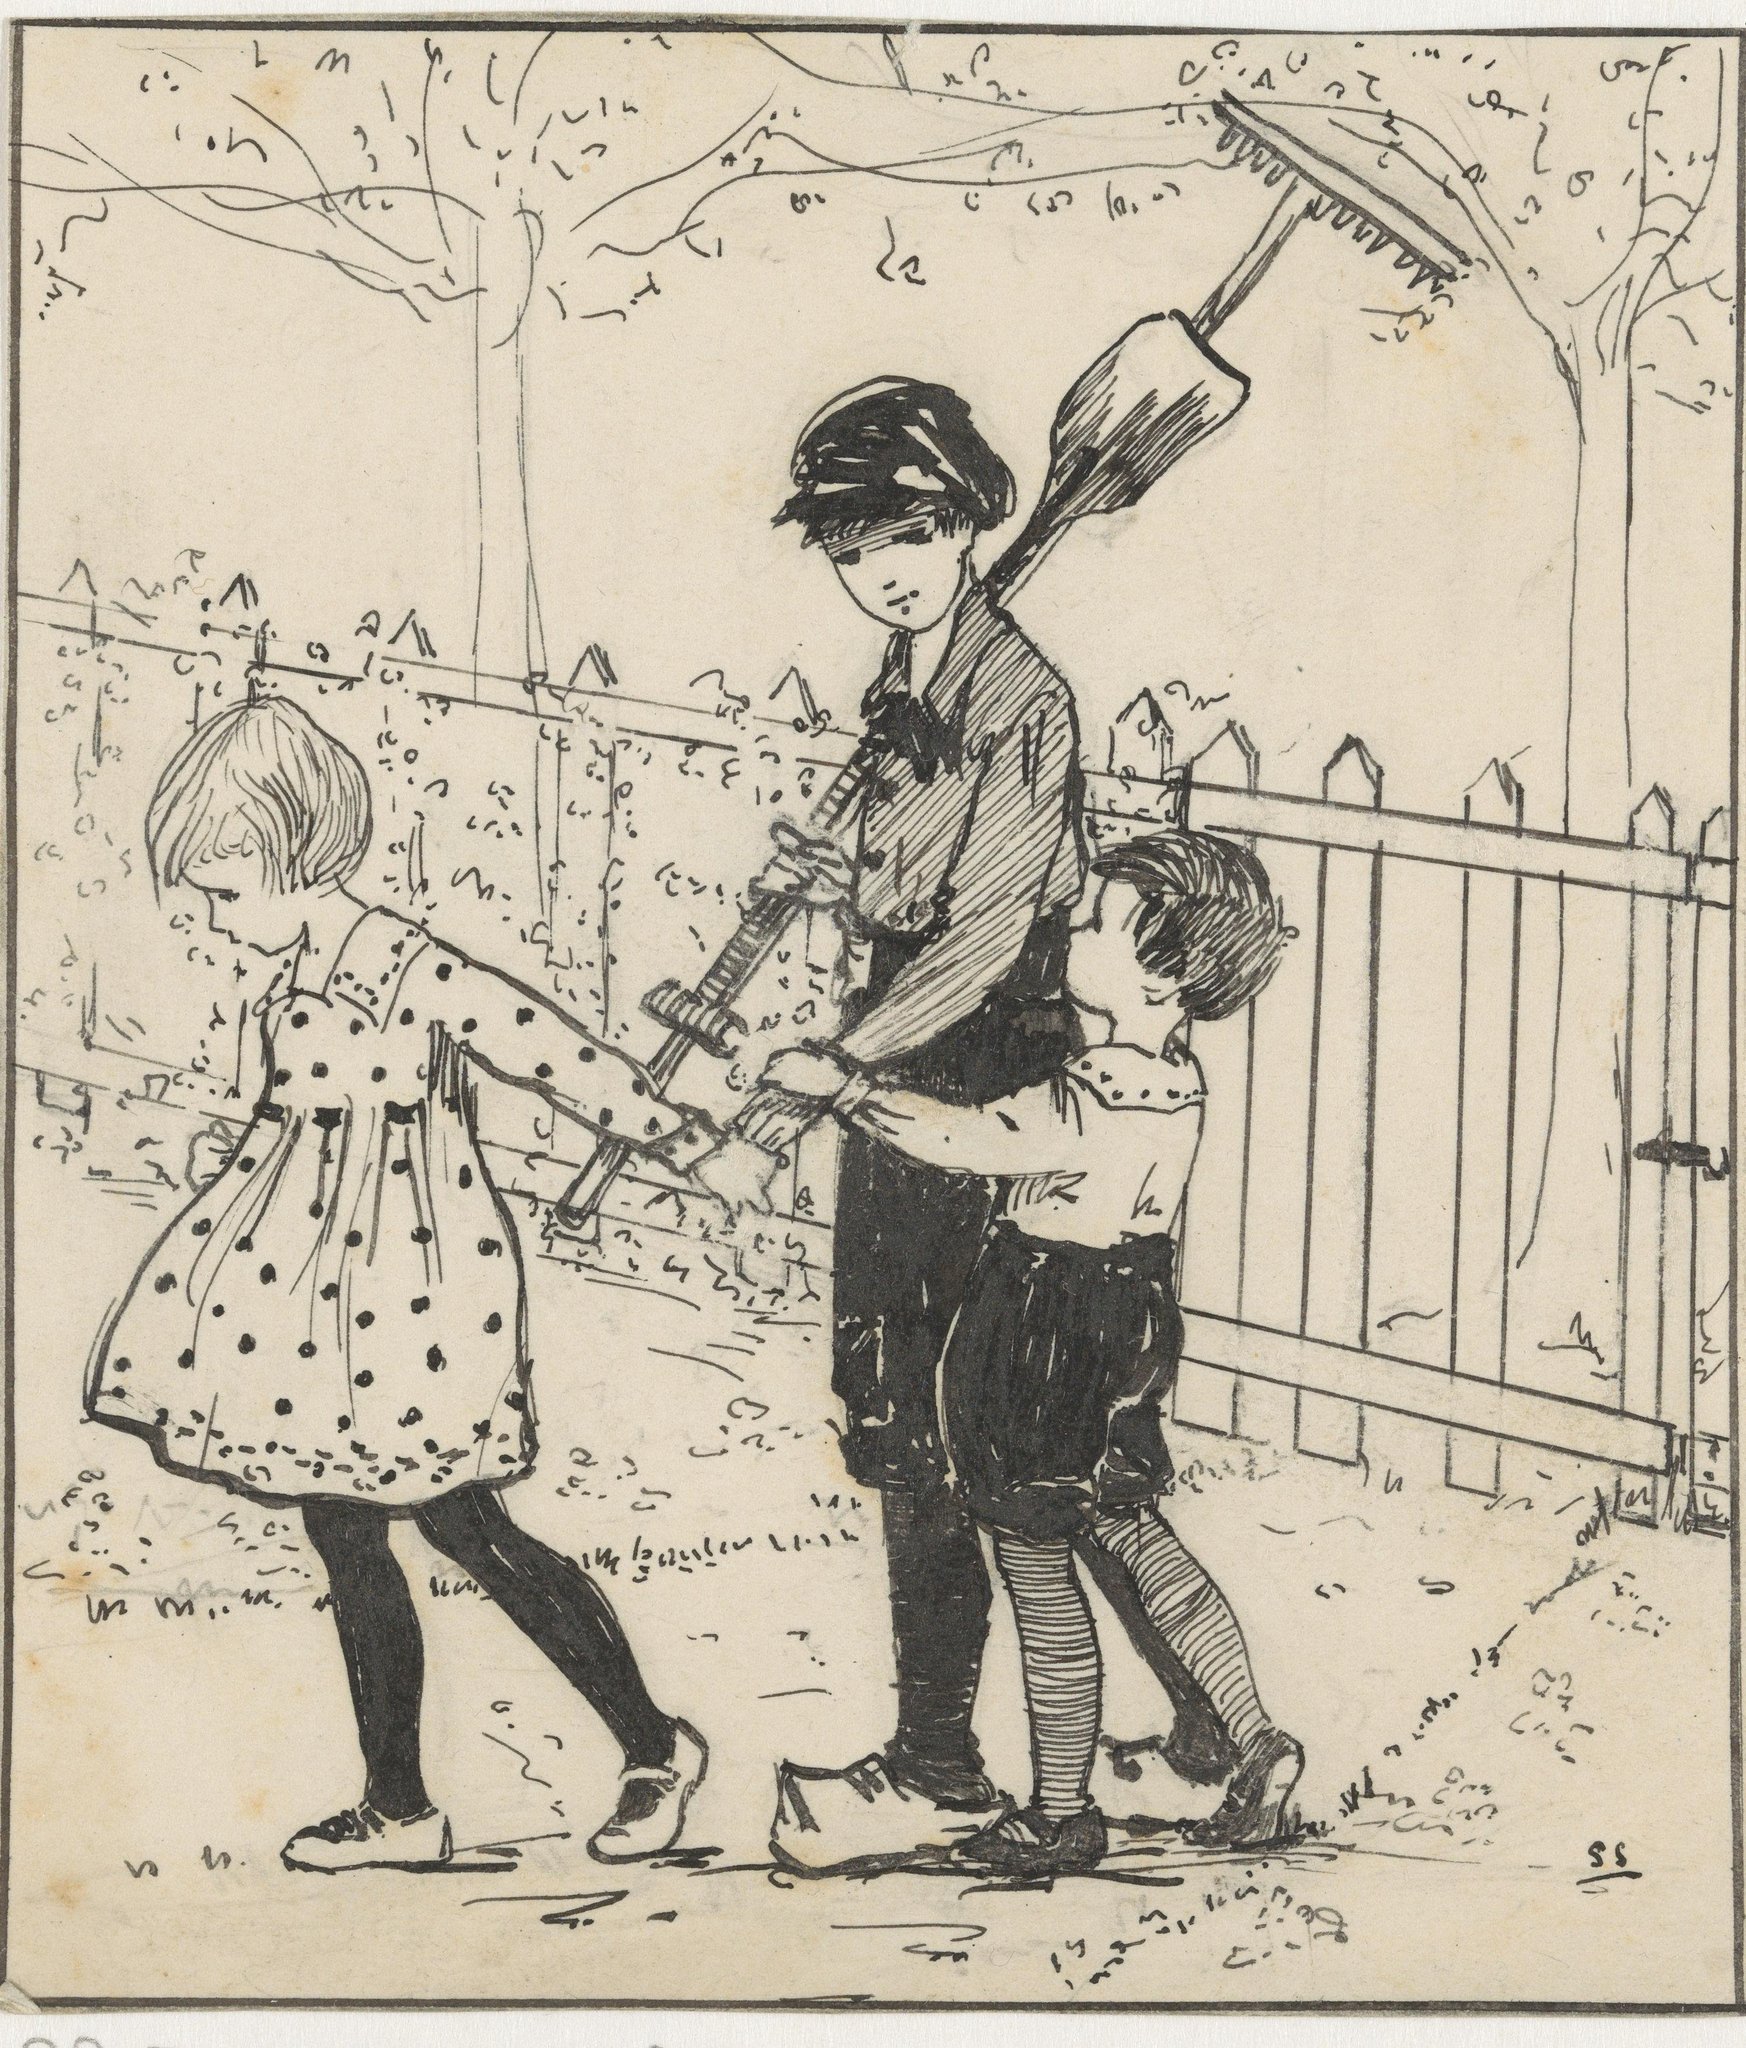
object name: boekillustratie ontwerp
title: Kinderen trekken aan arm van een jongen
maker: Anonymous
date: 1880-1930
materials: cardboard, ink, pencil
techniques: brush, pen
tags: fence, wall, paling, gardening-tools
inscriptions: signature: ‘SS’, collector's mark: Lugt 2228a, :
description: Een jongen en meisje trekken aan de arm van een oudere jongen die een schop en hark draagt. In de achtergrond een tuinhek.